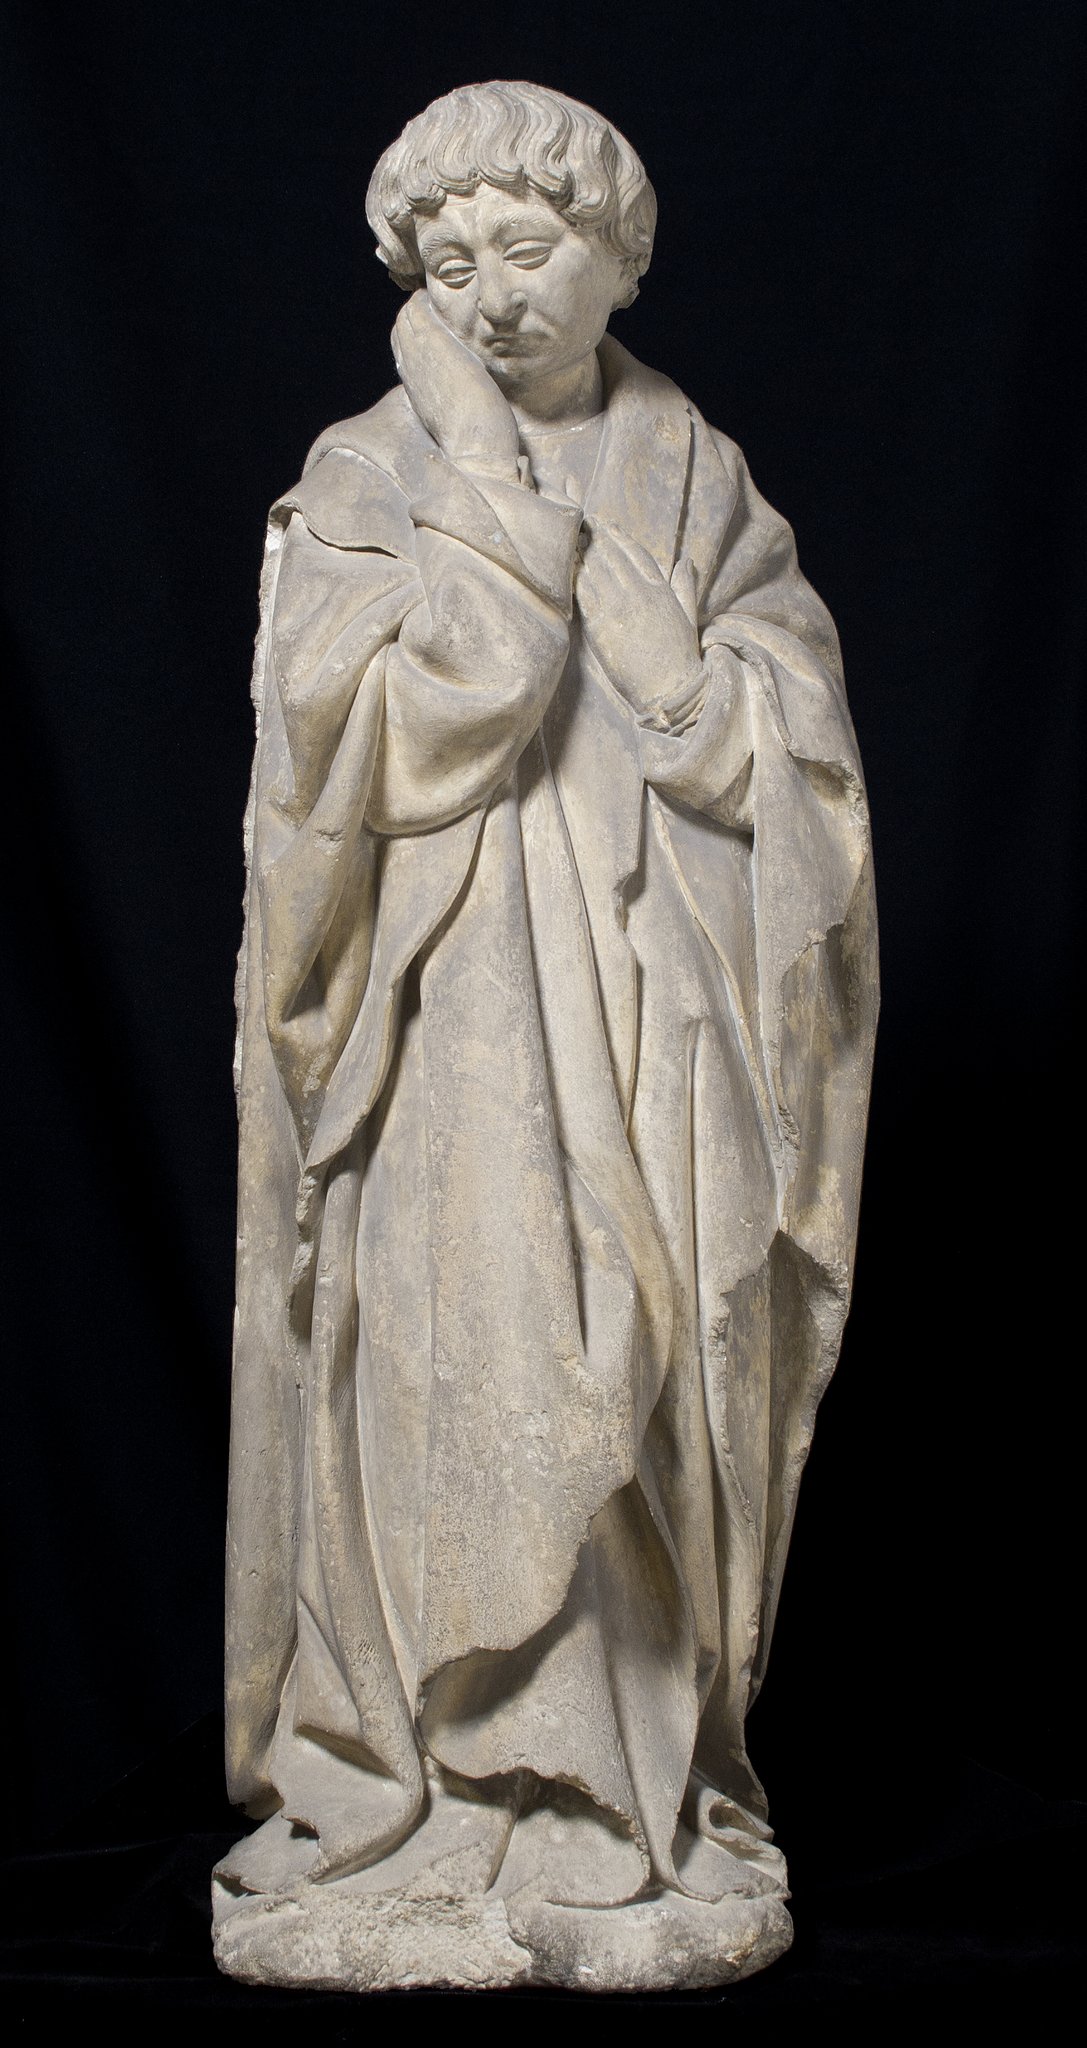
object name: statuette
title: Saint John the Evangelist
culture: french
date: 1425-1450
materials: stone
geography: france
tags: saint john the evangelist